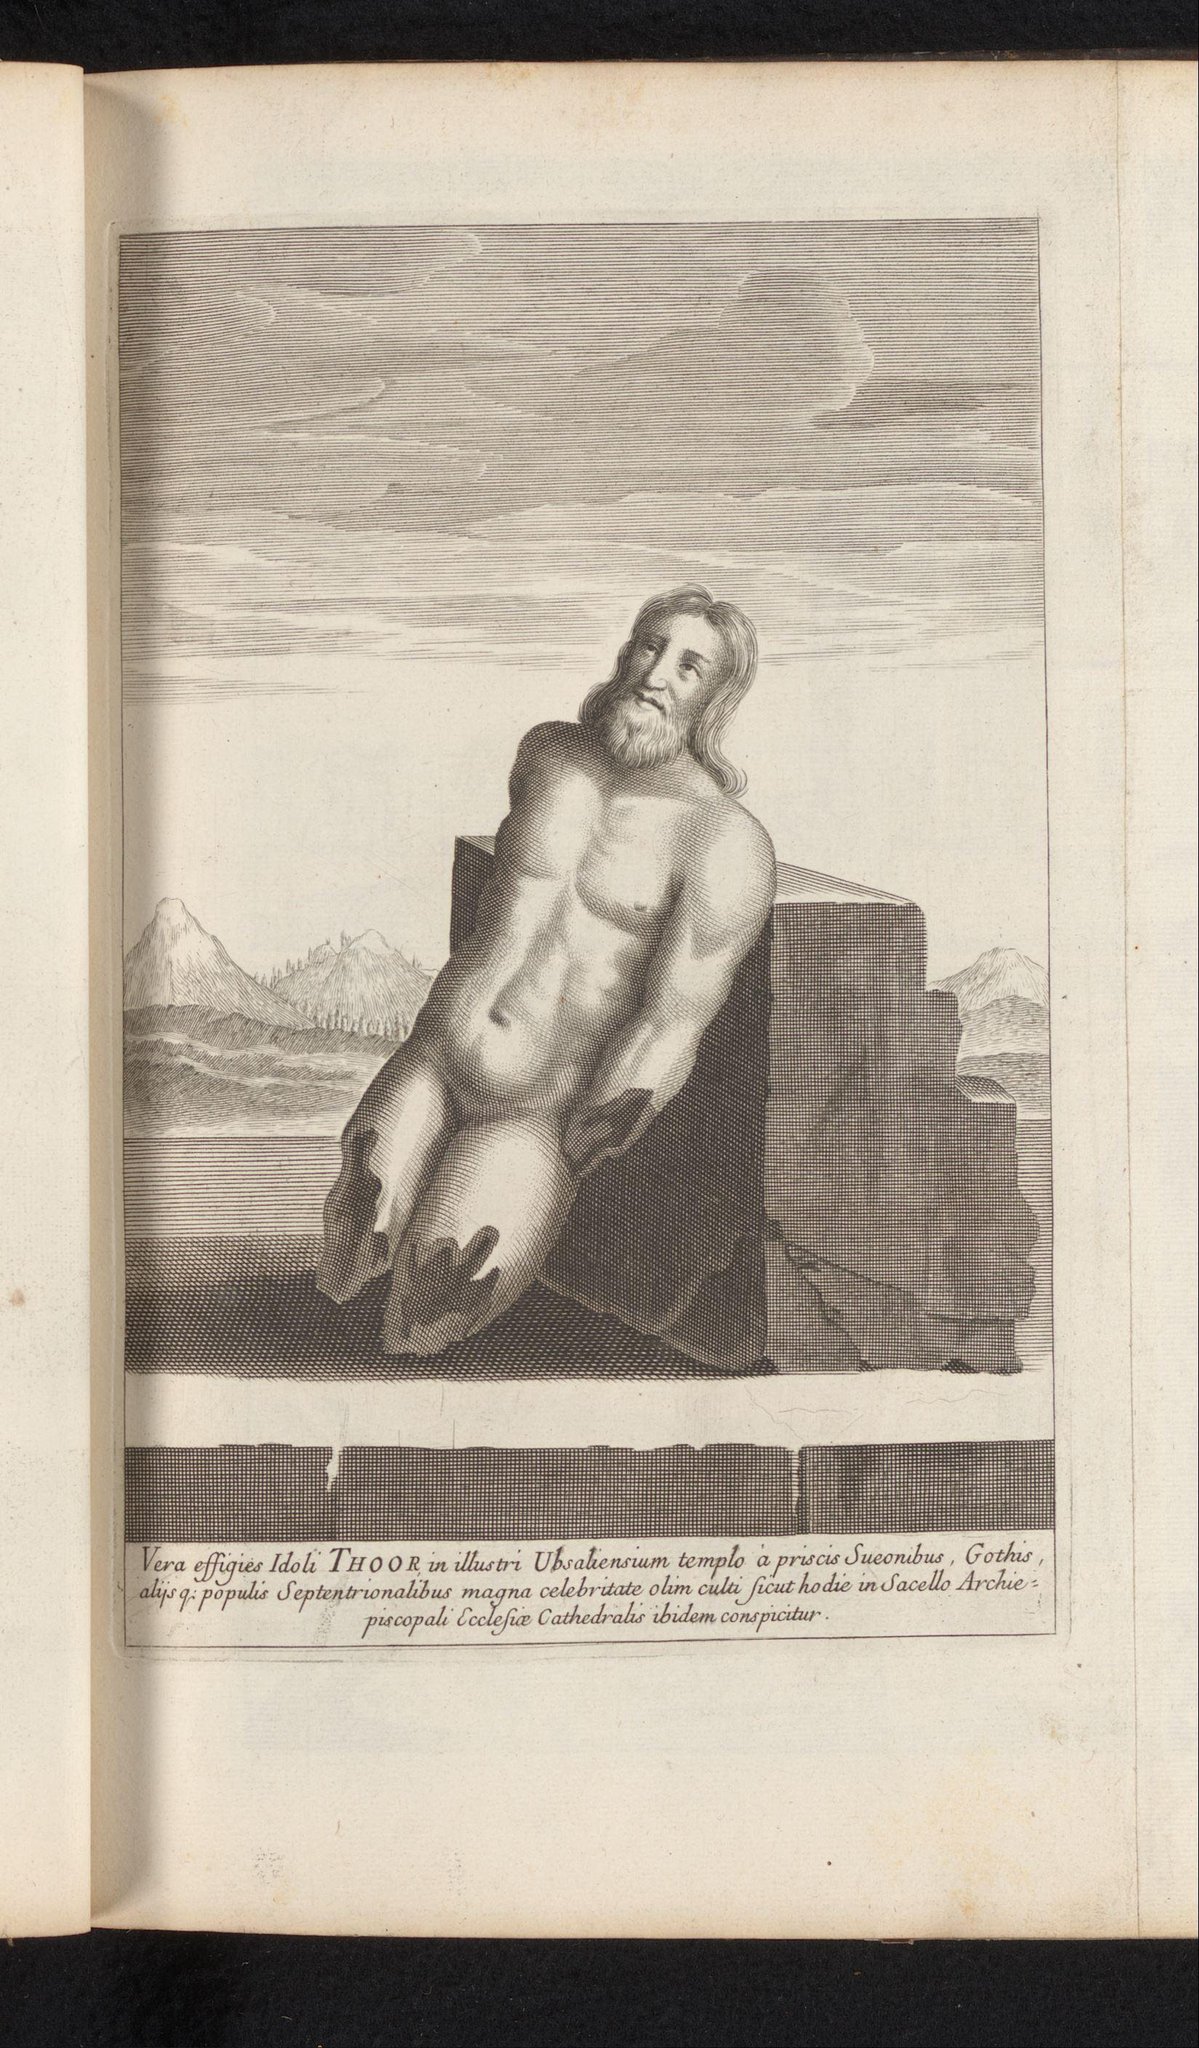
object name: print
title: Suecia Antiqua et Hodierna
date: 1668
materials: paper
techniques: etching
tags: thor, god of war and thunder, sculpture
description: Kungliga Biblioteket, 'Suecia': http://www.kb.se/samlingarna/Kartor-bilder/Suecia-antiqua/ (geraadpleegd november 2016).